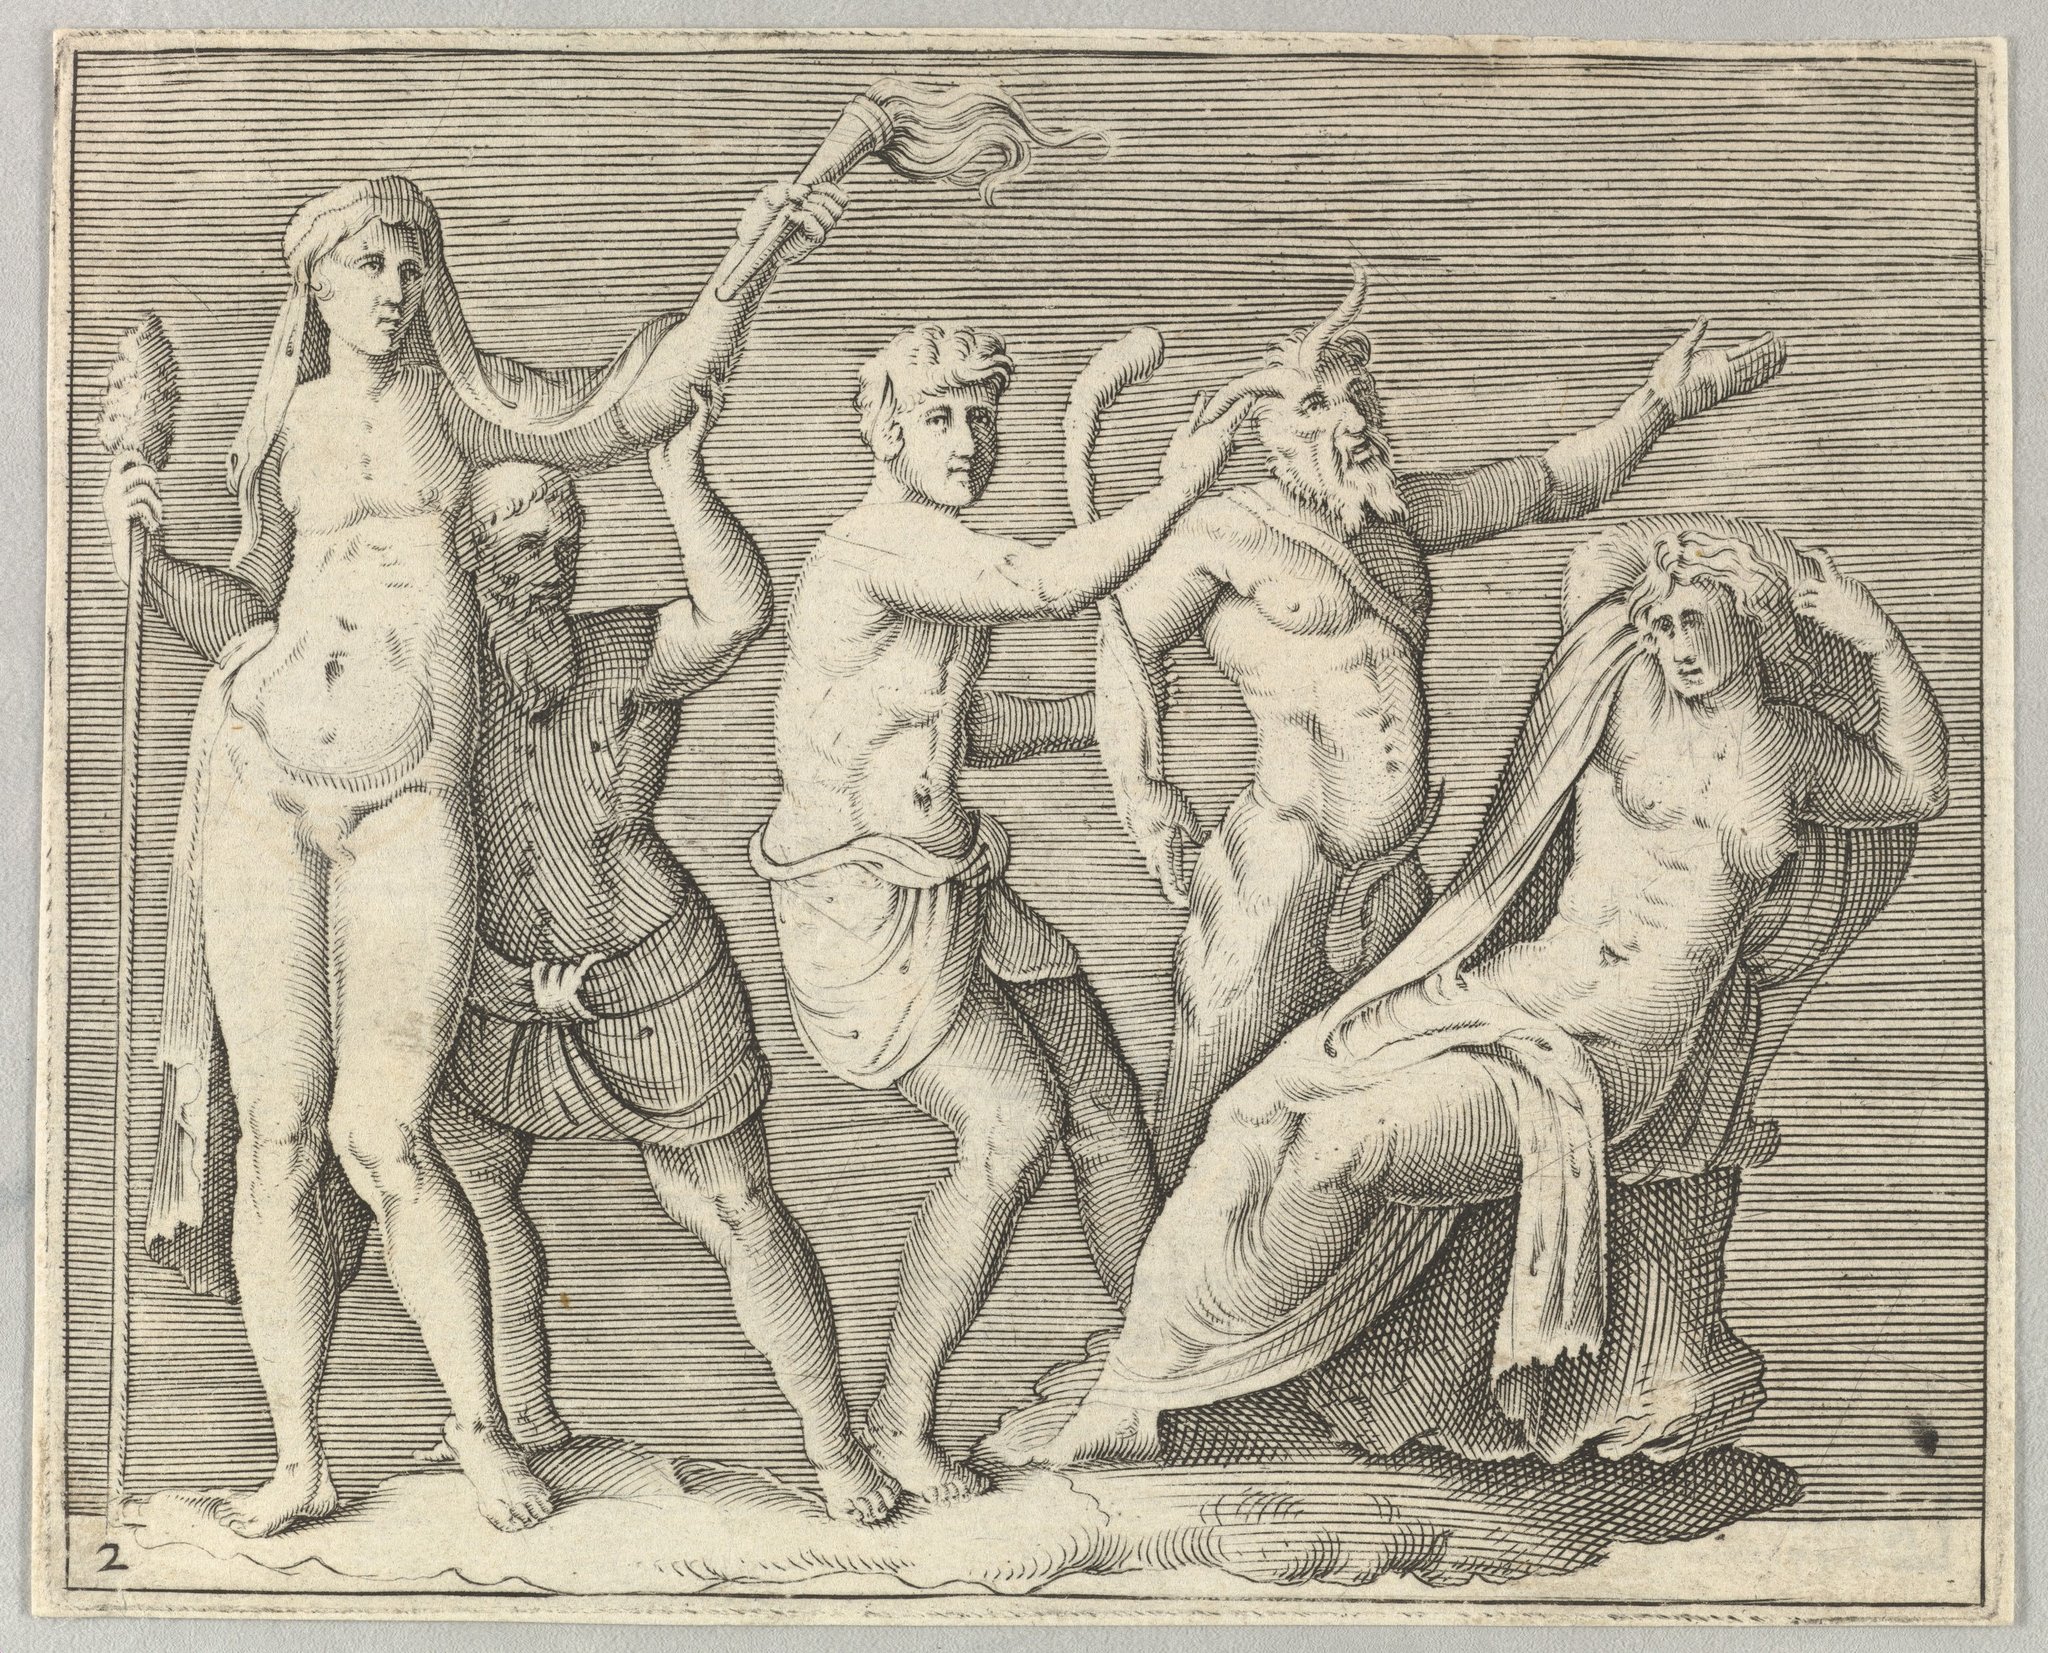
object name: print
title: Two Figures, a Faun, and a Satyr approach a Recliniing Woman, from "Ex Antiquis Cameorum et Gemmae Delineata/ Liber Secundus/et ab Enea Vico Parmen Incis"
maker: anonymous, italian, 16th century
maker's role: artist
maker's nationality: italian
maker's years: 1500-1600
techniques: engraving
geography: rome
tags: men,female nudes,fauns,satyrs